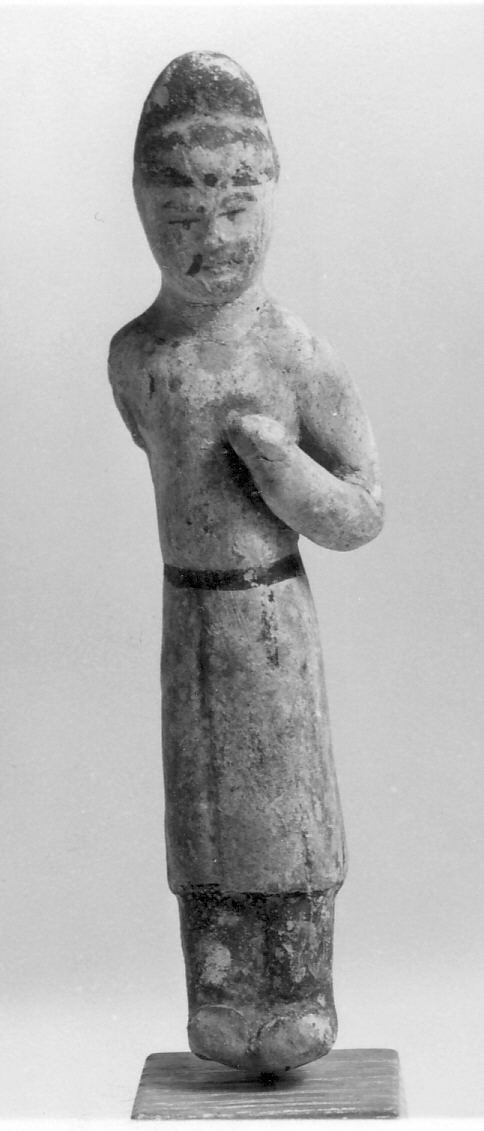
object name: figure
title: Male attendant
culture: chinese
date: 601-700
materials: clay, pigment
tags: men